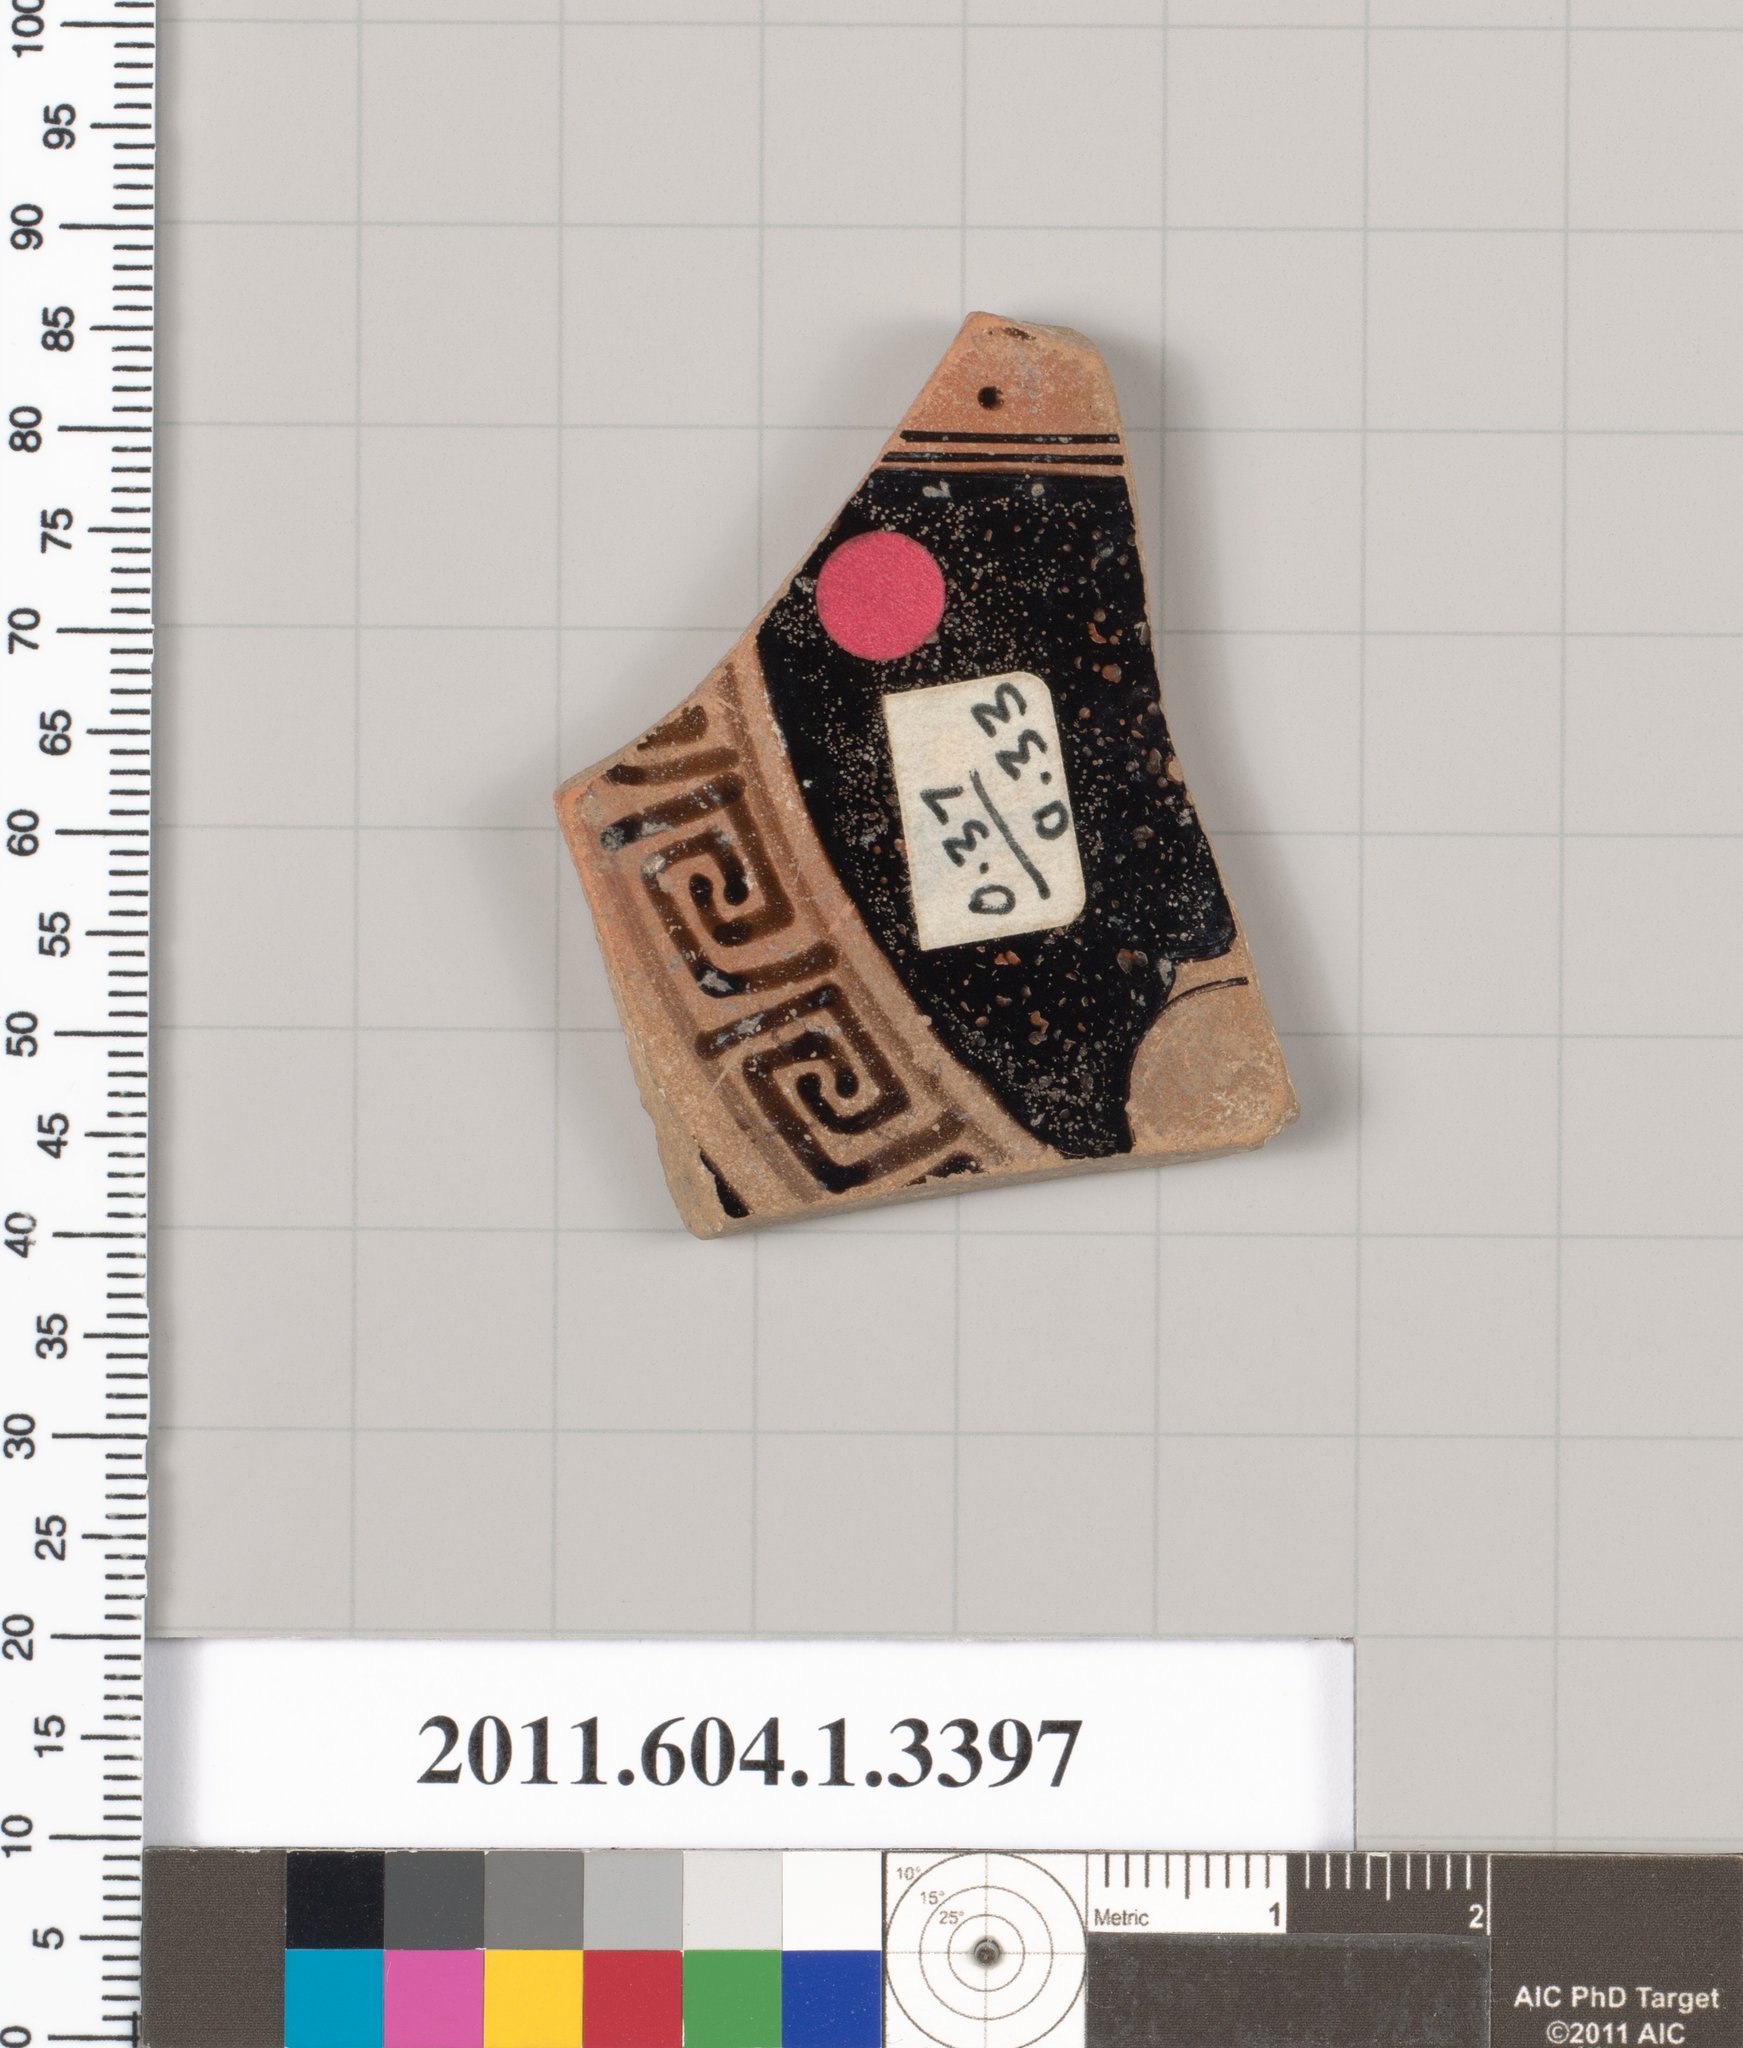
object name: kylix fragment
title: Terracotta fragment of a kylix (drinking cup)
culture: greek, attic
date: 500-476 BCE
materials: terracotta